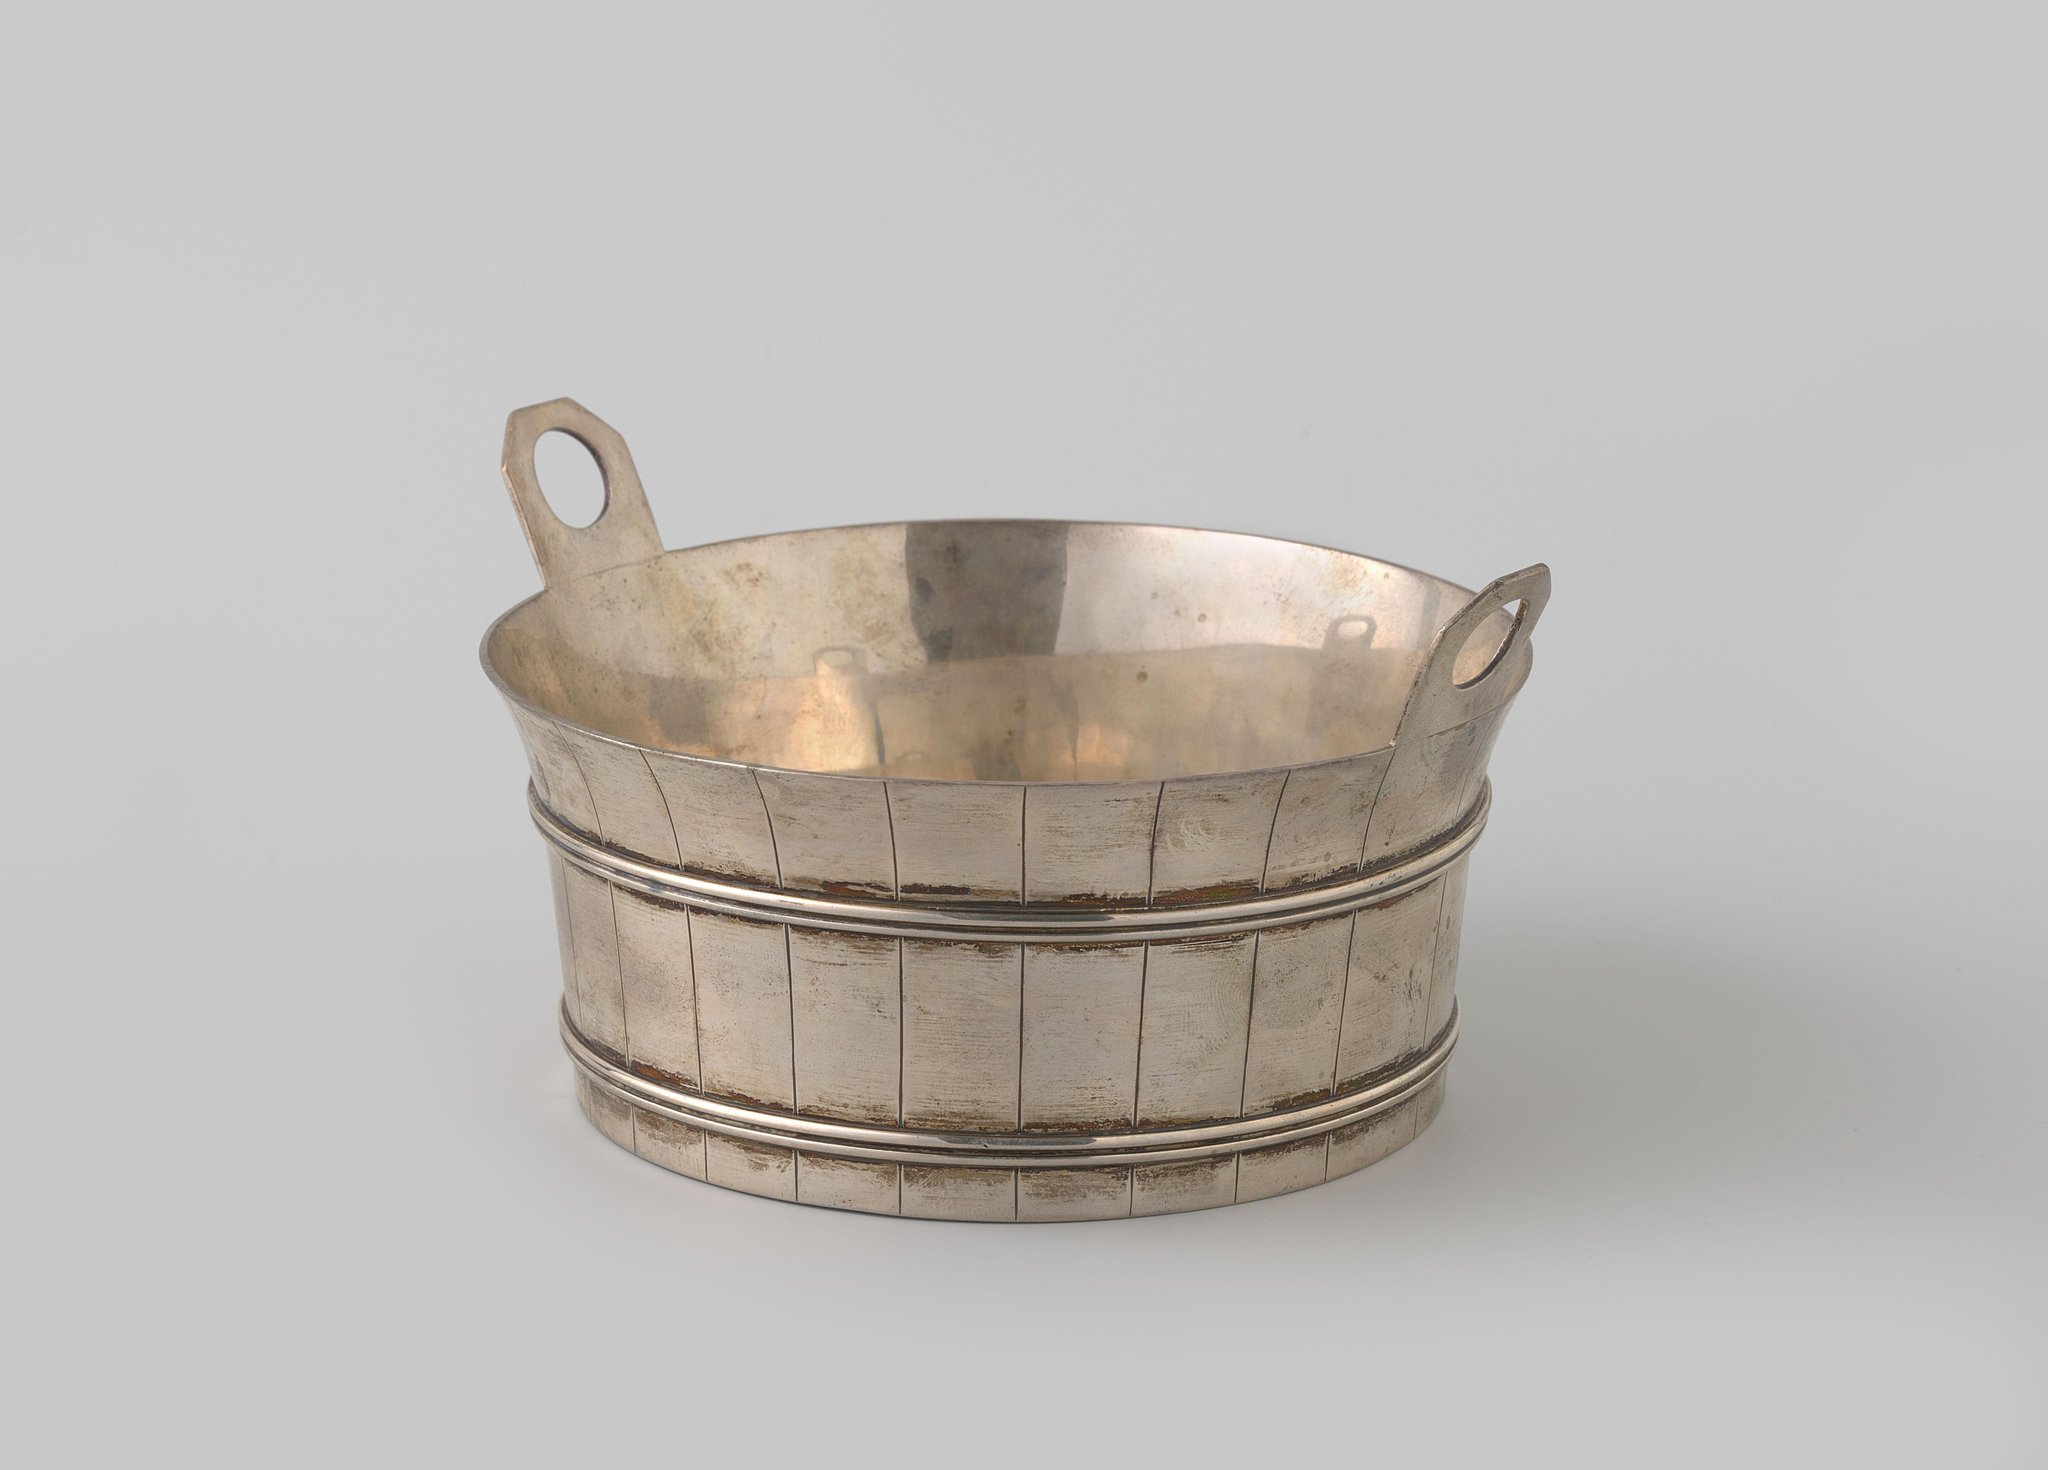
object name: container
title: Bak van zilver in de vorm van een tobbe, met twee schuin opstaande oren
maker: Anonymous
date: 1814-1819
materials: silver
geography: vienna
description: Bak van zilver, in de vorm van een tobbe. Met 2 schuin opstaande oren. Meesterteken: FS.